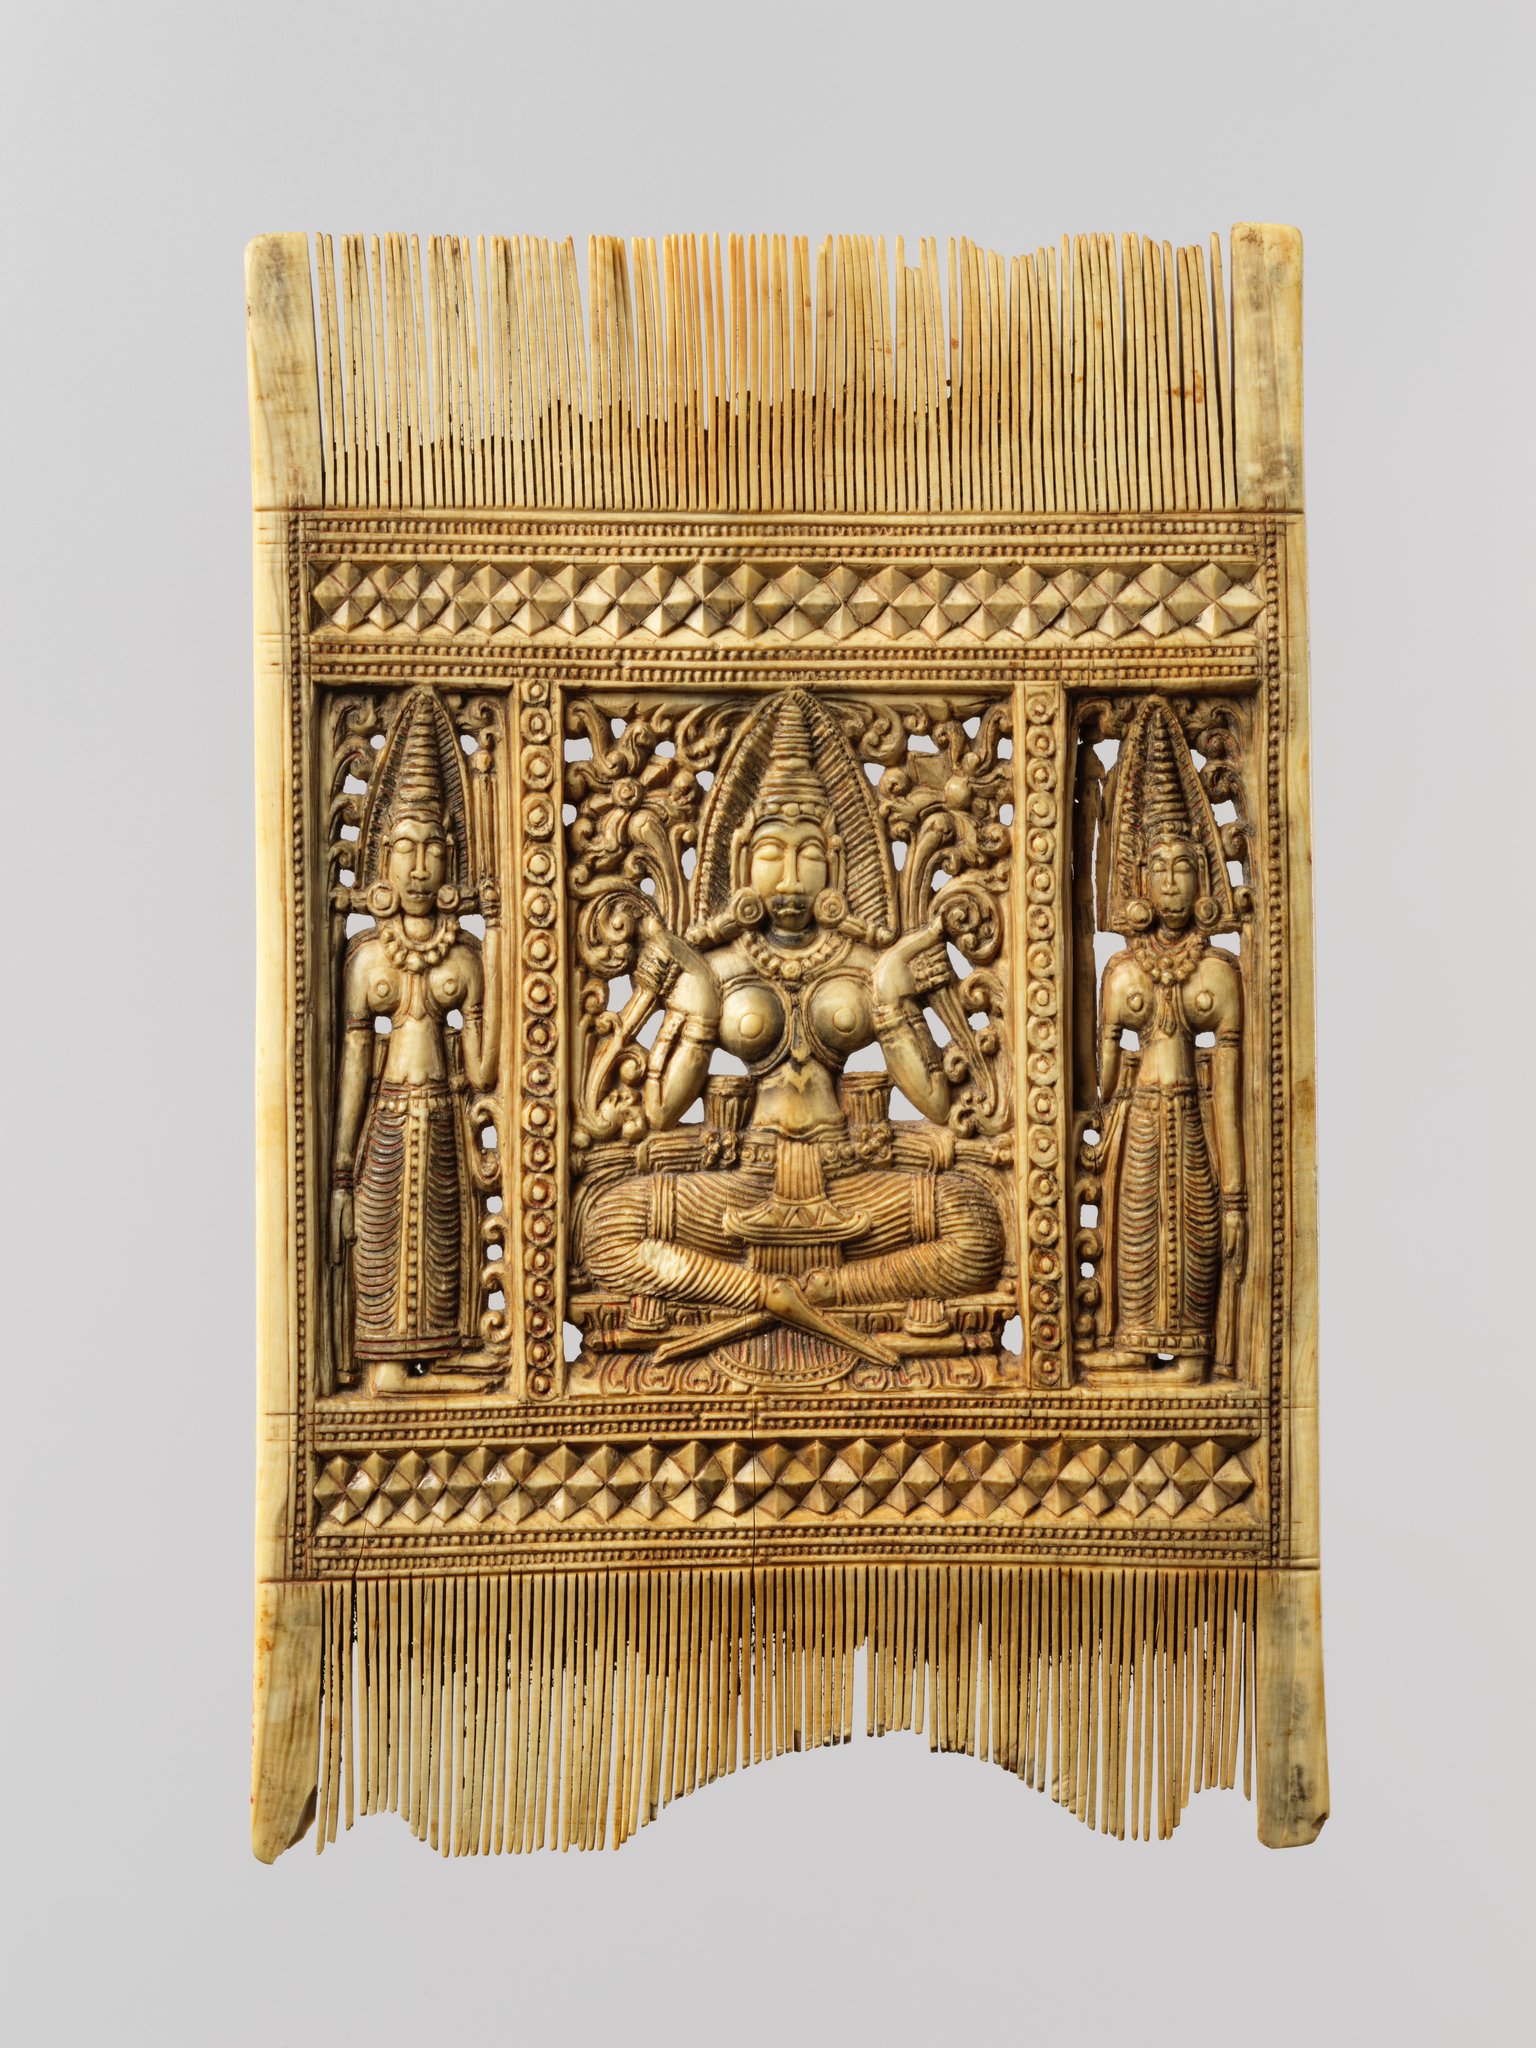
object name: comb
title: Comb with the Goddess Lakshmi and Attendants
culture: sri lankan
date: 1701-1800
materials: ivory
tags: goddess